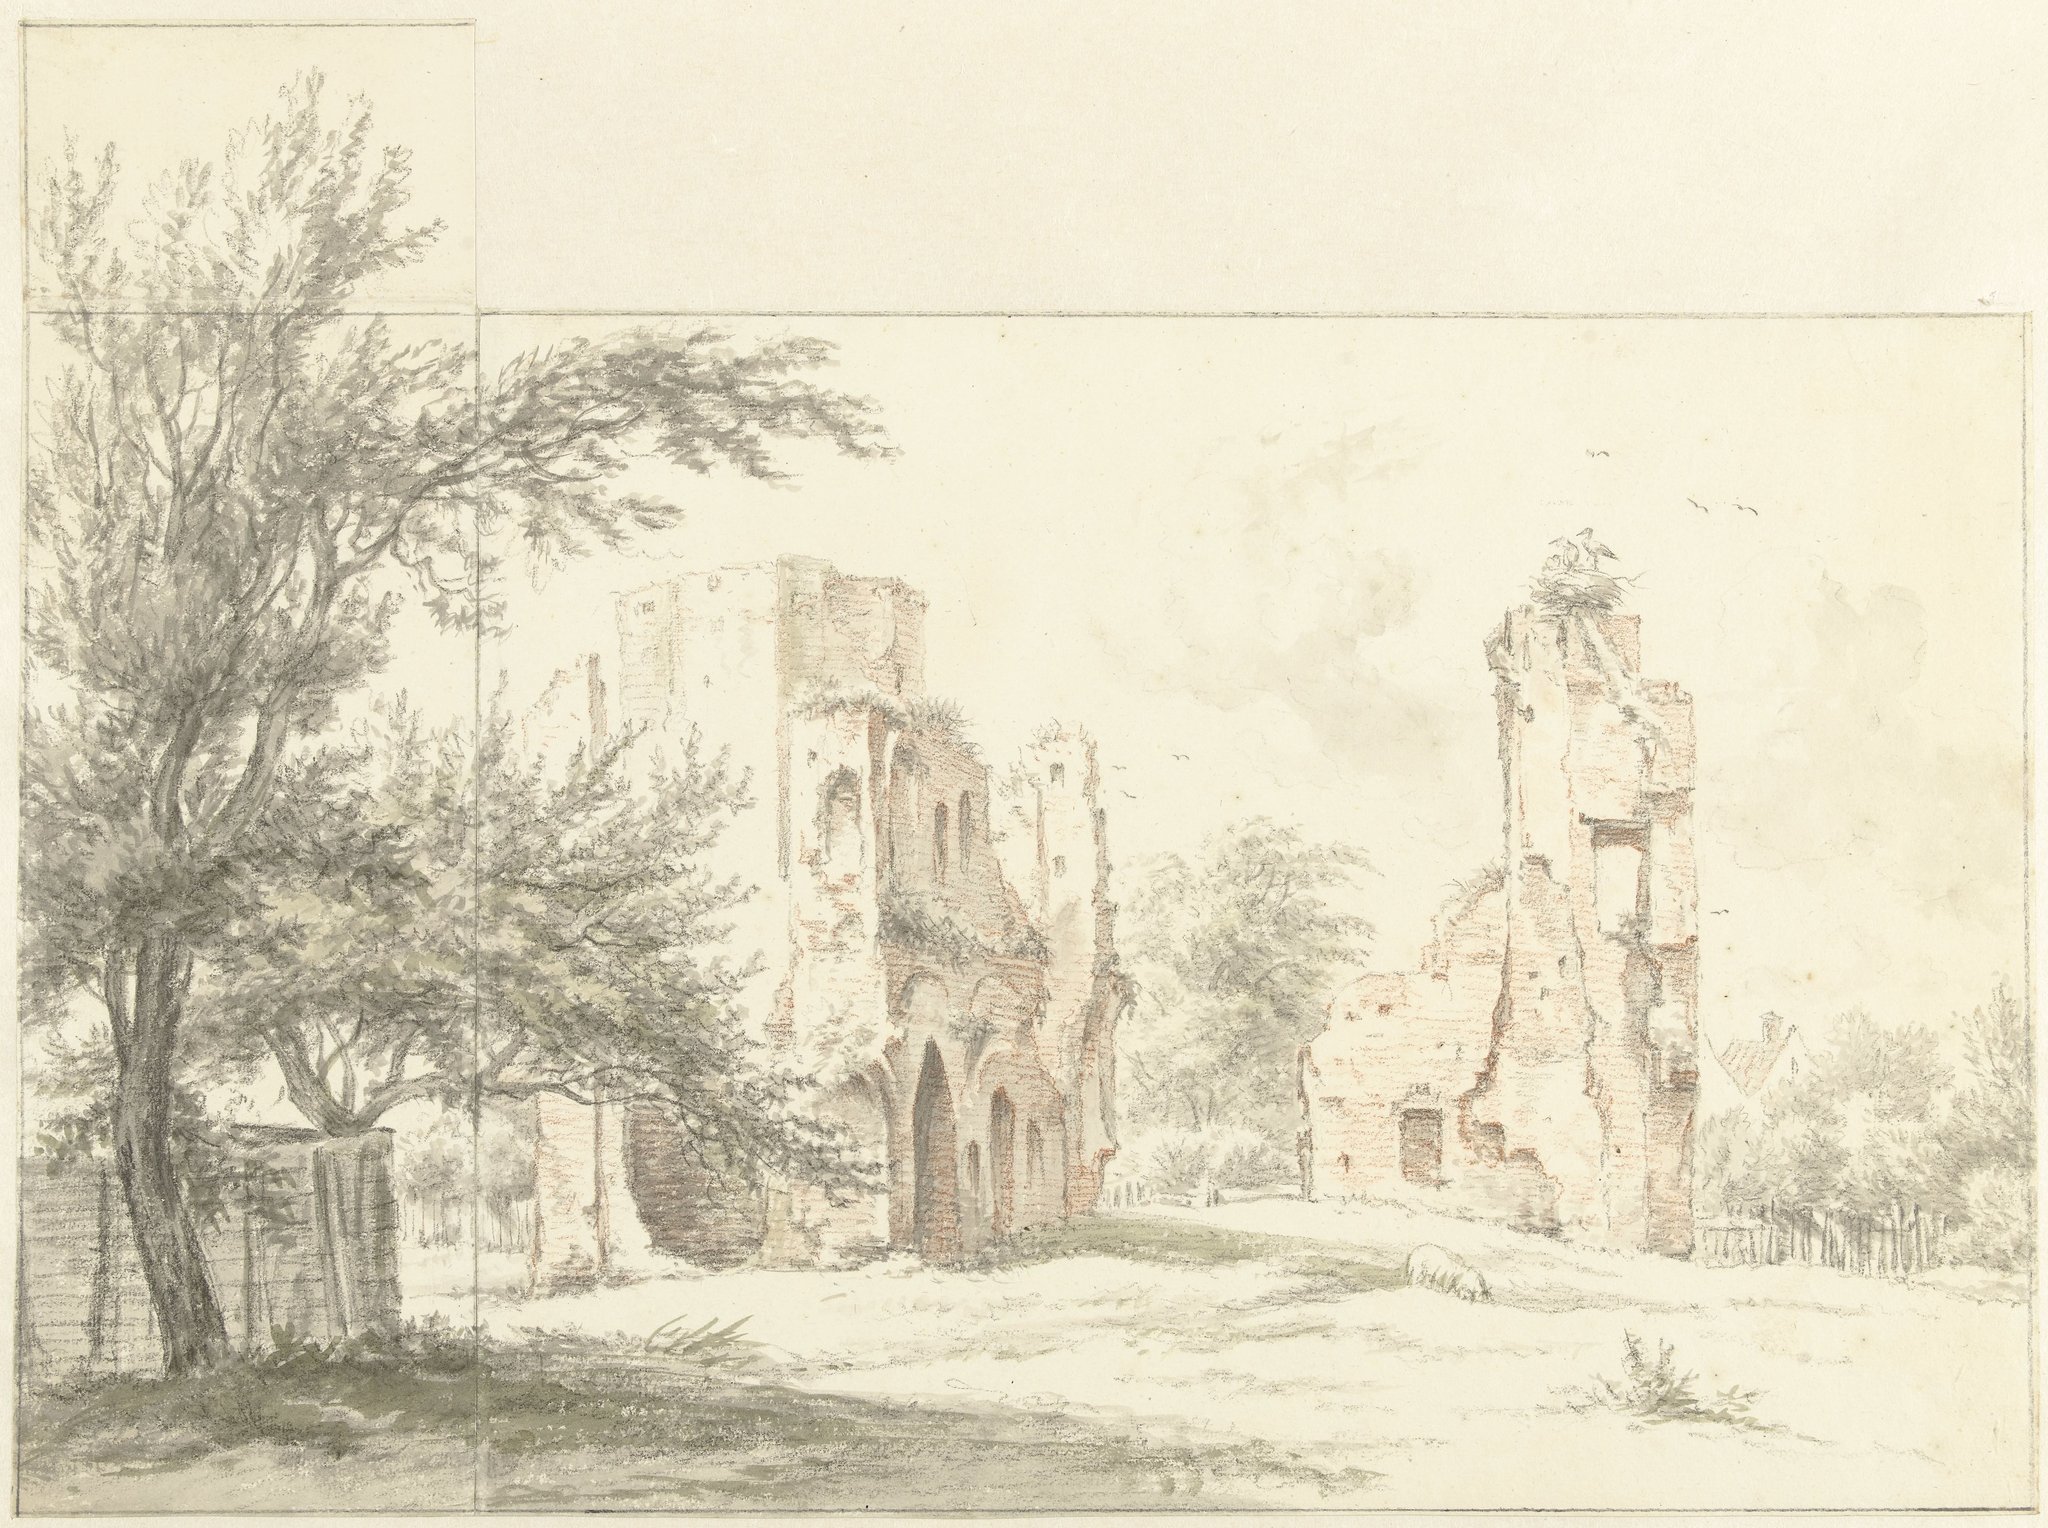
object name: drawing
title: Ruïne van Rijnsburg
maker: egbert van drielst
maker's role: draughtsman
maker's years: 1745-1818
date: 1803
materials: chalk, paper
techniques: brush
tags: ruin of a building ~ architecture, abbey, monastery, convent ~ roman catholic church